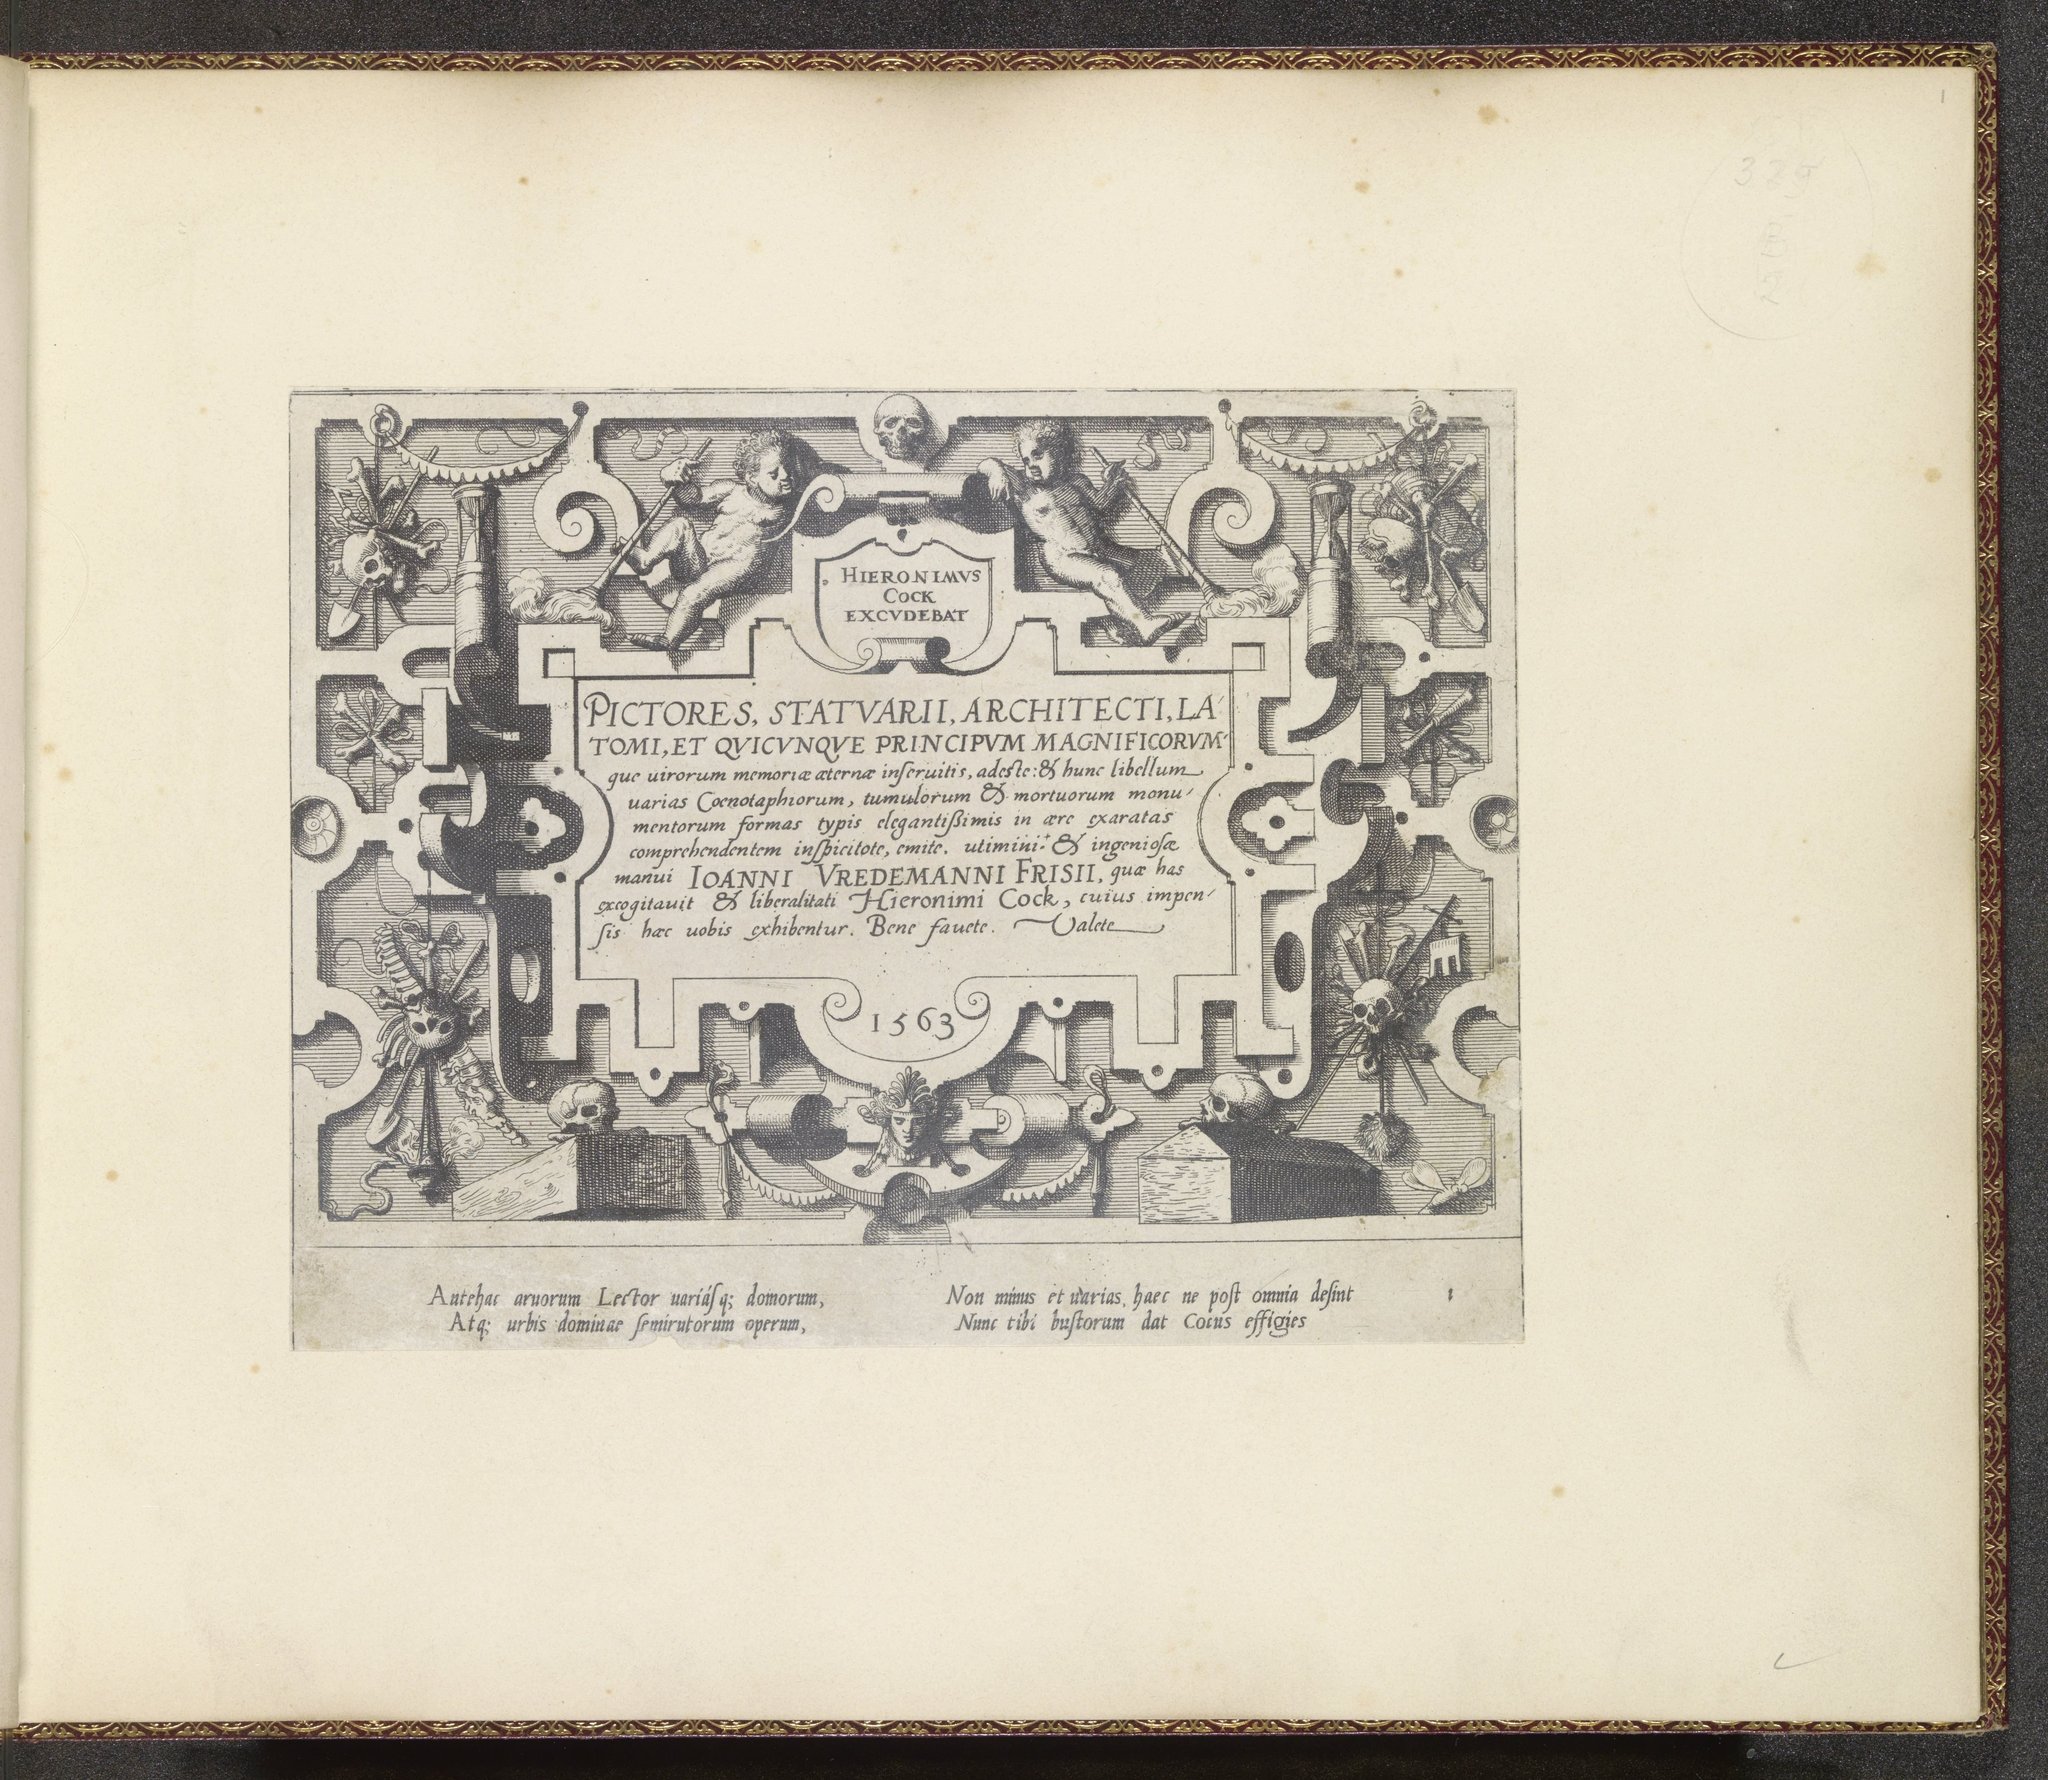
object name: ornament print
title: Pictores, statuarii, architecti, latomi, et quicunque principum magnificorumque uirorum memoriae aeternae inseruitis, adeste & hunc libellum uarias coenotaphiorum, tumulorum & mortuorum monumentorum formas, 1563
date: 1563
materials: paper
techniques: etching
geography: antwerp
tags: bones (symbol of death), title-page, ornamental decoration ~ printed matter, book, ornament ~ cartouche, mask, mascaron ~ ornament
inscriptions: date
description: Titelprent met een cartouche in een omlijsting van rol- en beslagwerk. Bovenaan twee putti en rondom menselijke botten en schedels als trofeeën. Onderaan twee doodskisten. In de ondermarge vier regels tekst, in twee kolommen, in het Latijn. De prent maakt deel uit van een album.